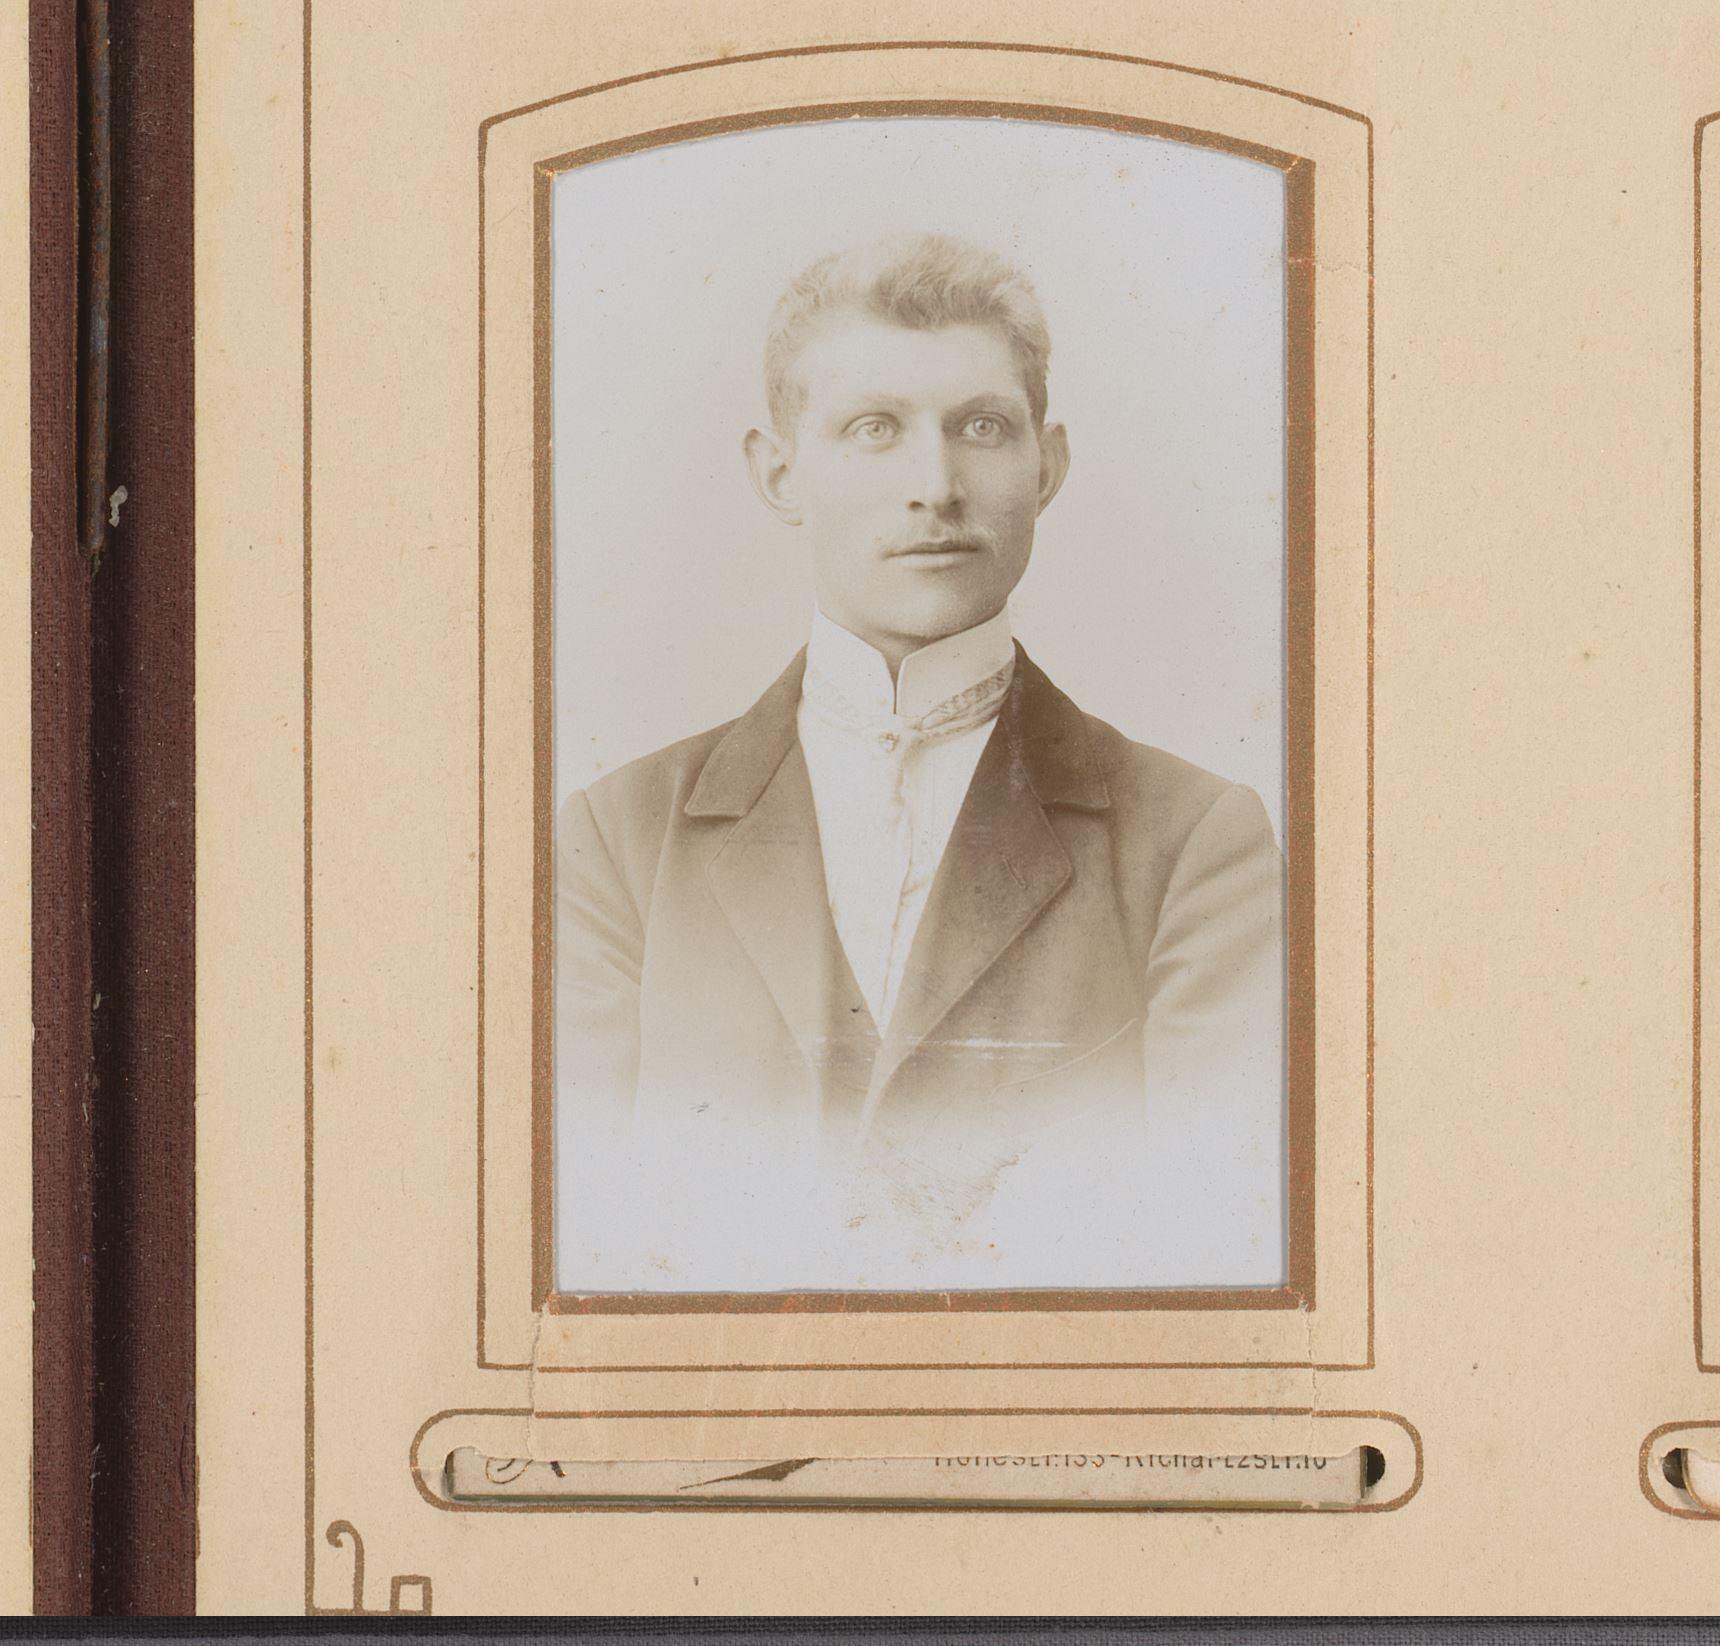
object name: album leaf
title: Portret van een man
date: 1880-1910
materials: cardboard, photographic support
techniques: albumen print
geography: cologne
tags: historical persons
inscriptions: inscription: ‘Atelier J. Fuchs/ Köln/ Hohestr. 133-Richartzstr.10’